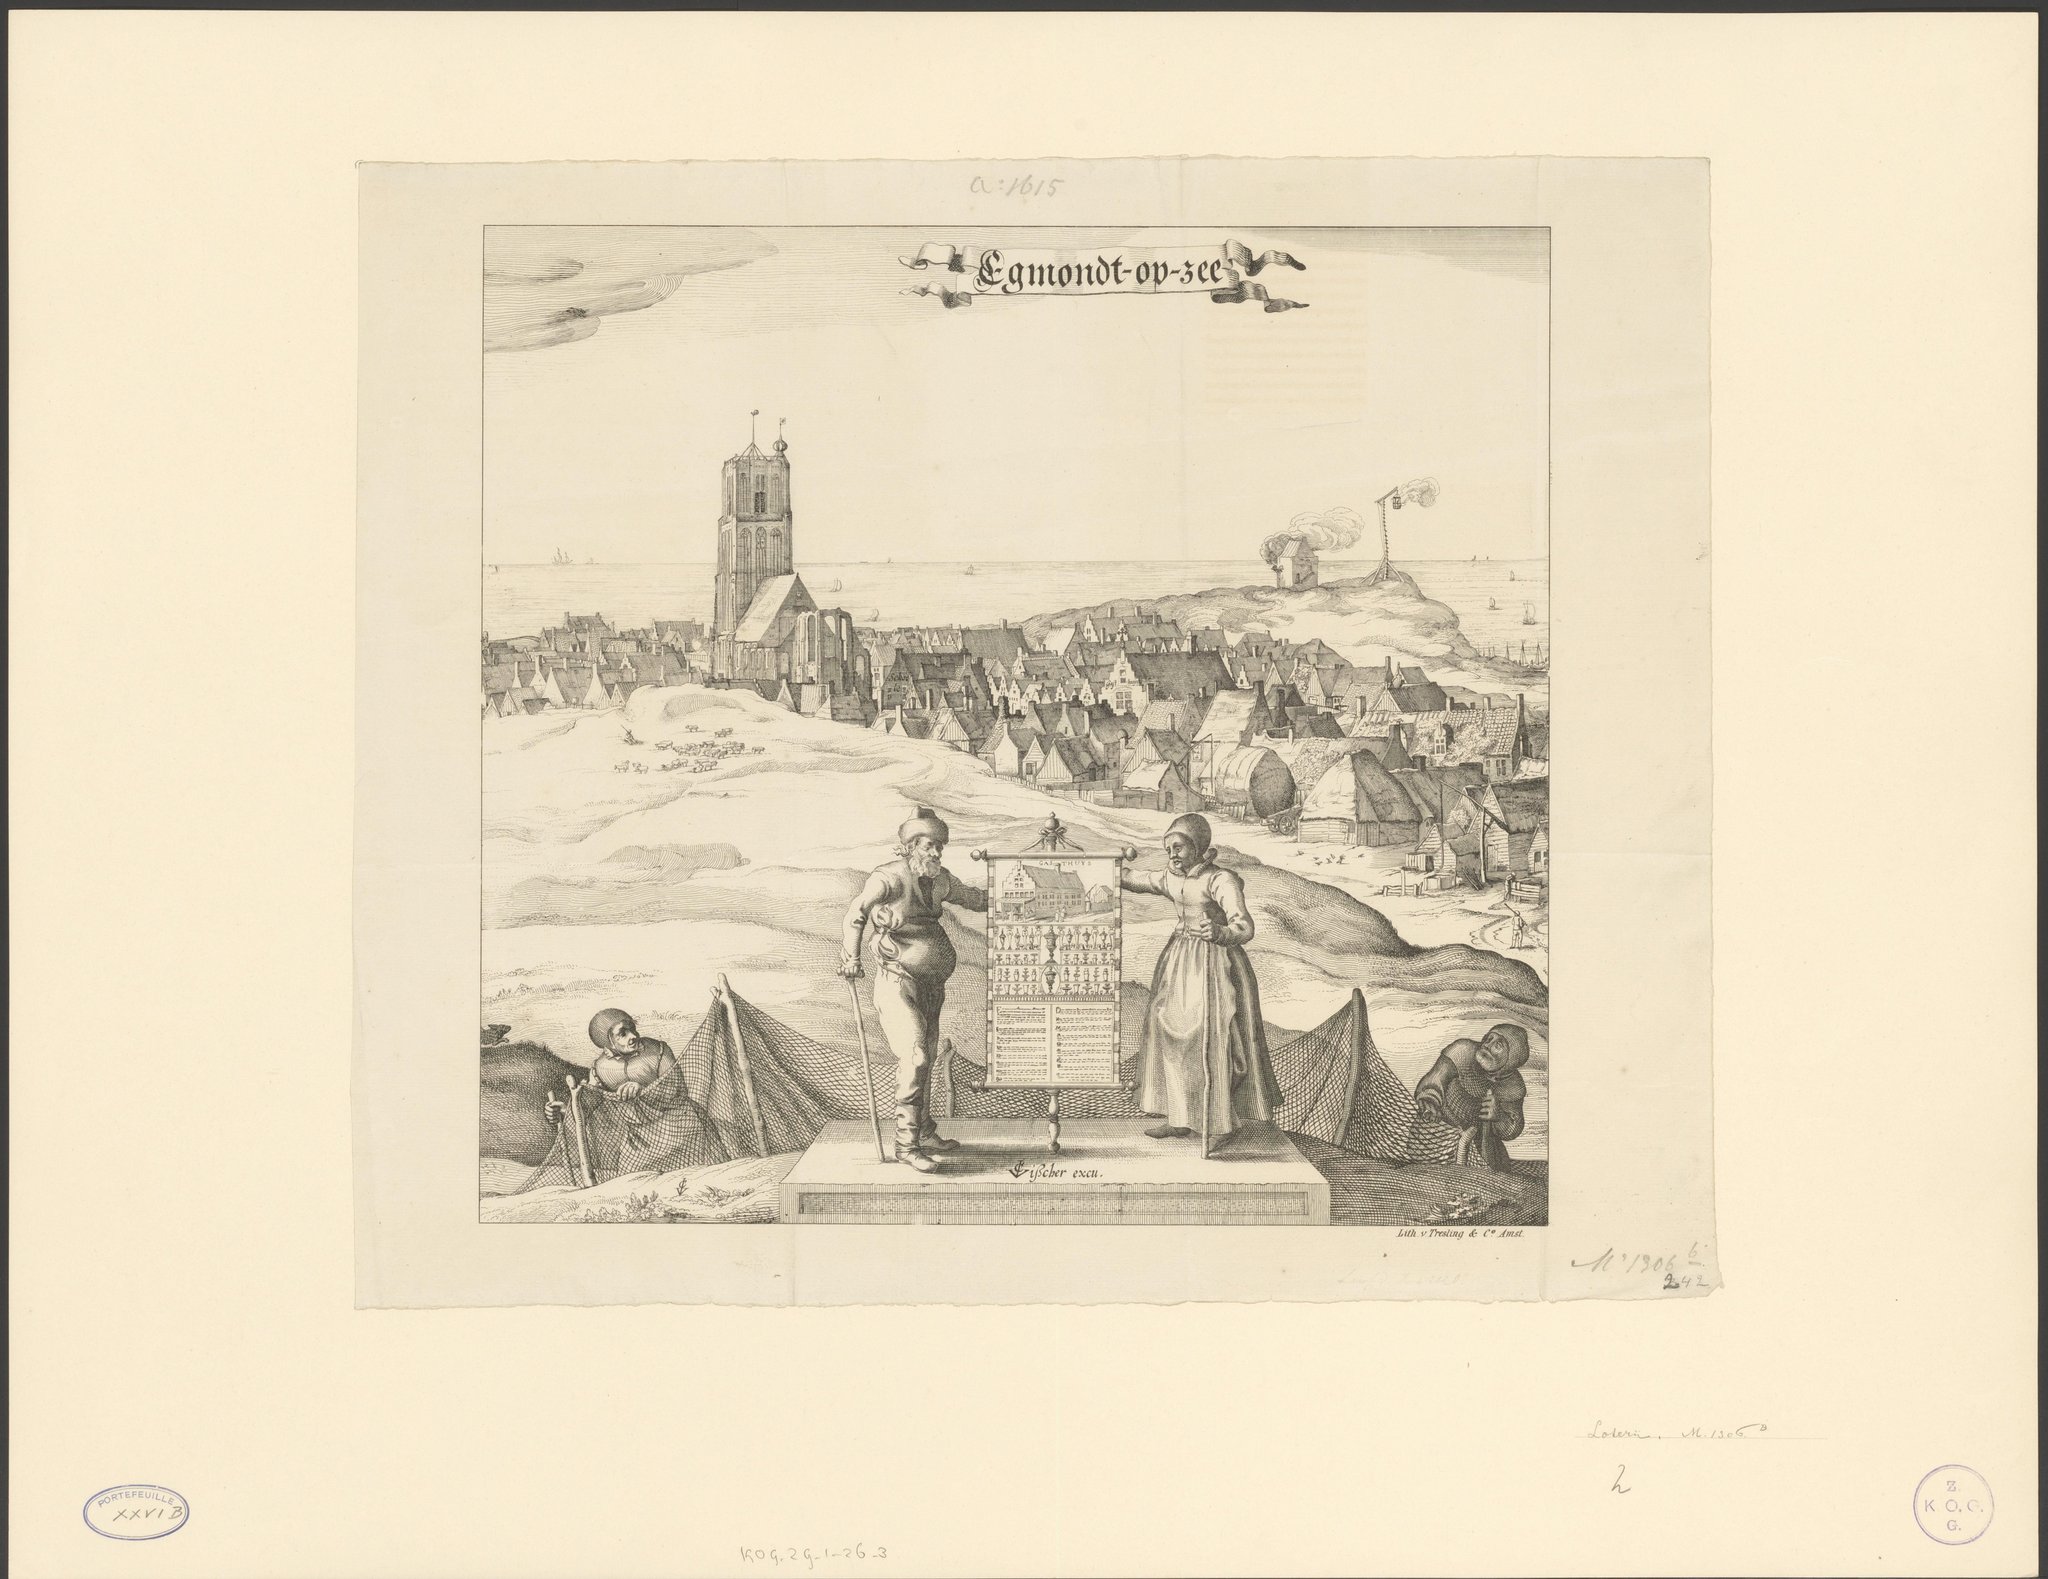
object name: print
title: Loterij ten behoeve van een nieuw gasthuis in Egmond aan Zee, ca. 1618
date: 1860-1862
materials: paper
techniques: lithograph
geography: amsterdam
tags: raffle, lottery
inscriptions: collector's mark, collector's mark: Lugt 1641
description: De loterij te Egmond aan Zee ten behoeve van een nieuw gasthuis, ca. 1618. Op de voorgrond een oude man en vrouw die een loterijprent omhoog houden met een afbeelding van het nieuwe gasthuis en de te winnen prijzen en het reglement. Achter hen een visser en een visvrouw met een visnet. Op de achtergrond het dorp aan de kust. Bij de prent een blaadje met informatie over de voorstelling. Moderne druk. Onderwerpsrubrieken binnen de Atlas Zeden en Gewoonten: Spel en Vermaak; Loterij.